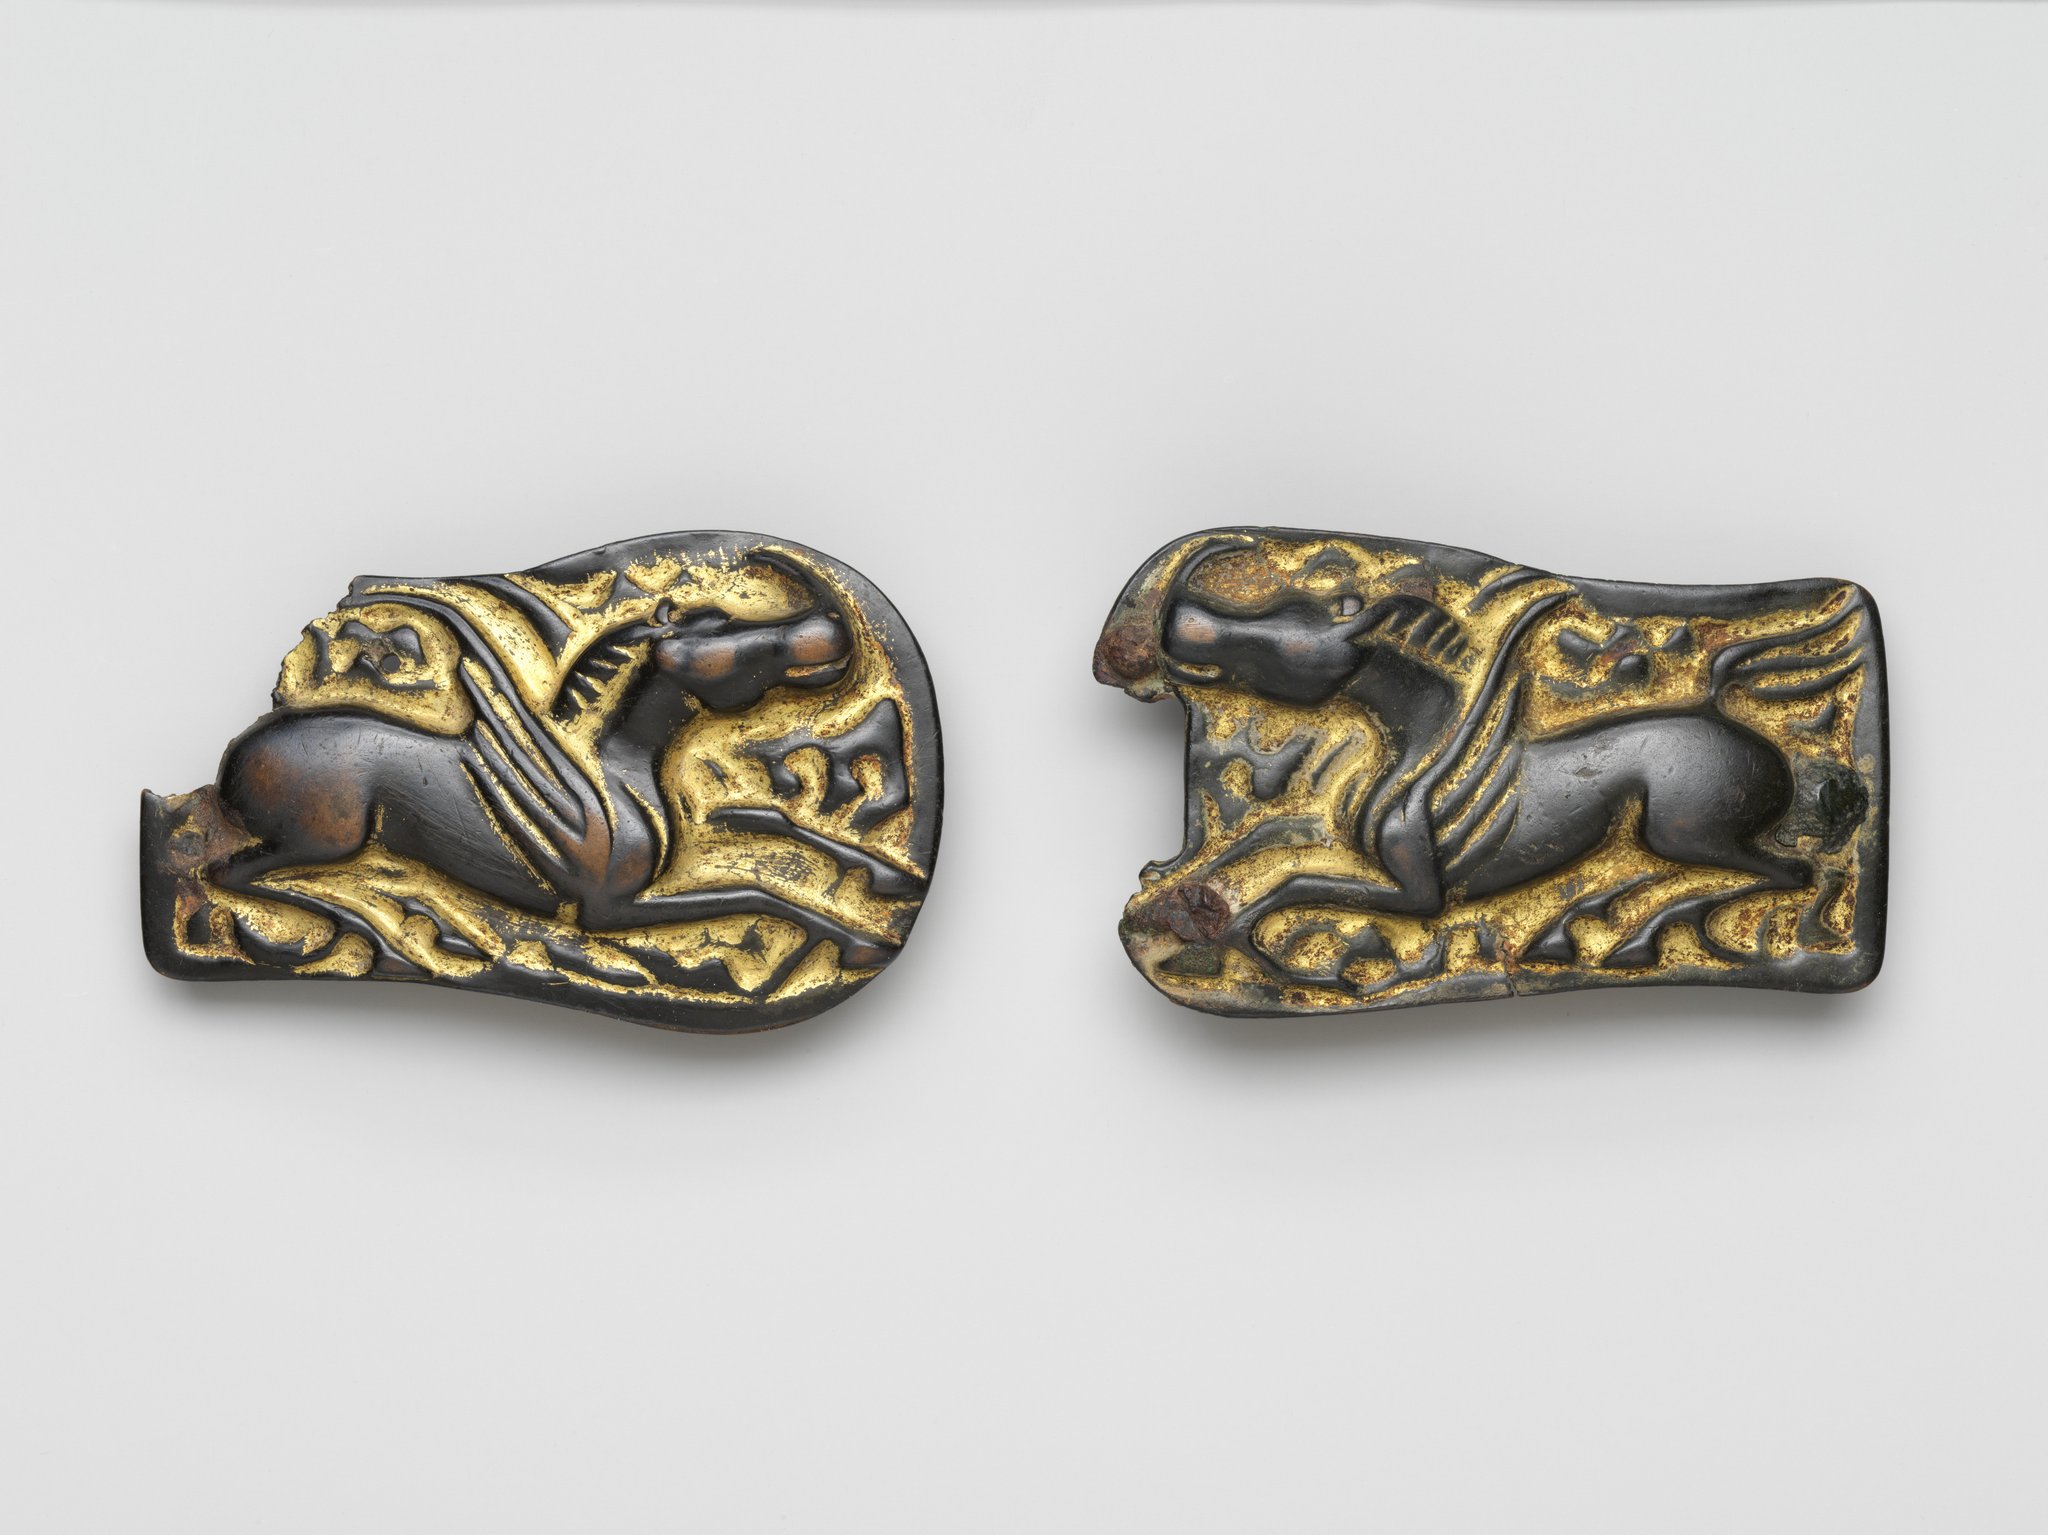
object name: belt plaque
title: Pair of Belt Plaques with Winged Horses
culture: chinese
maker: unidentified artist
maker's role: artist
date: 1-100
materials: bronze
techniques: gilding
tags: horses